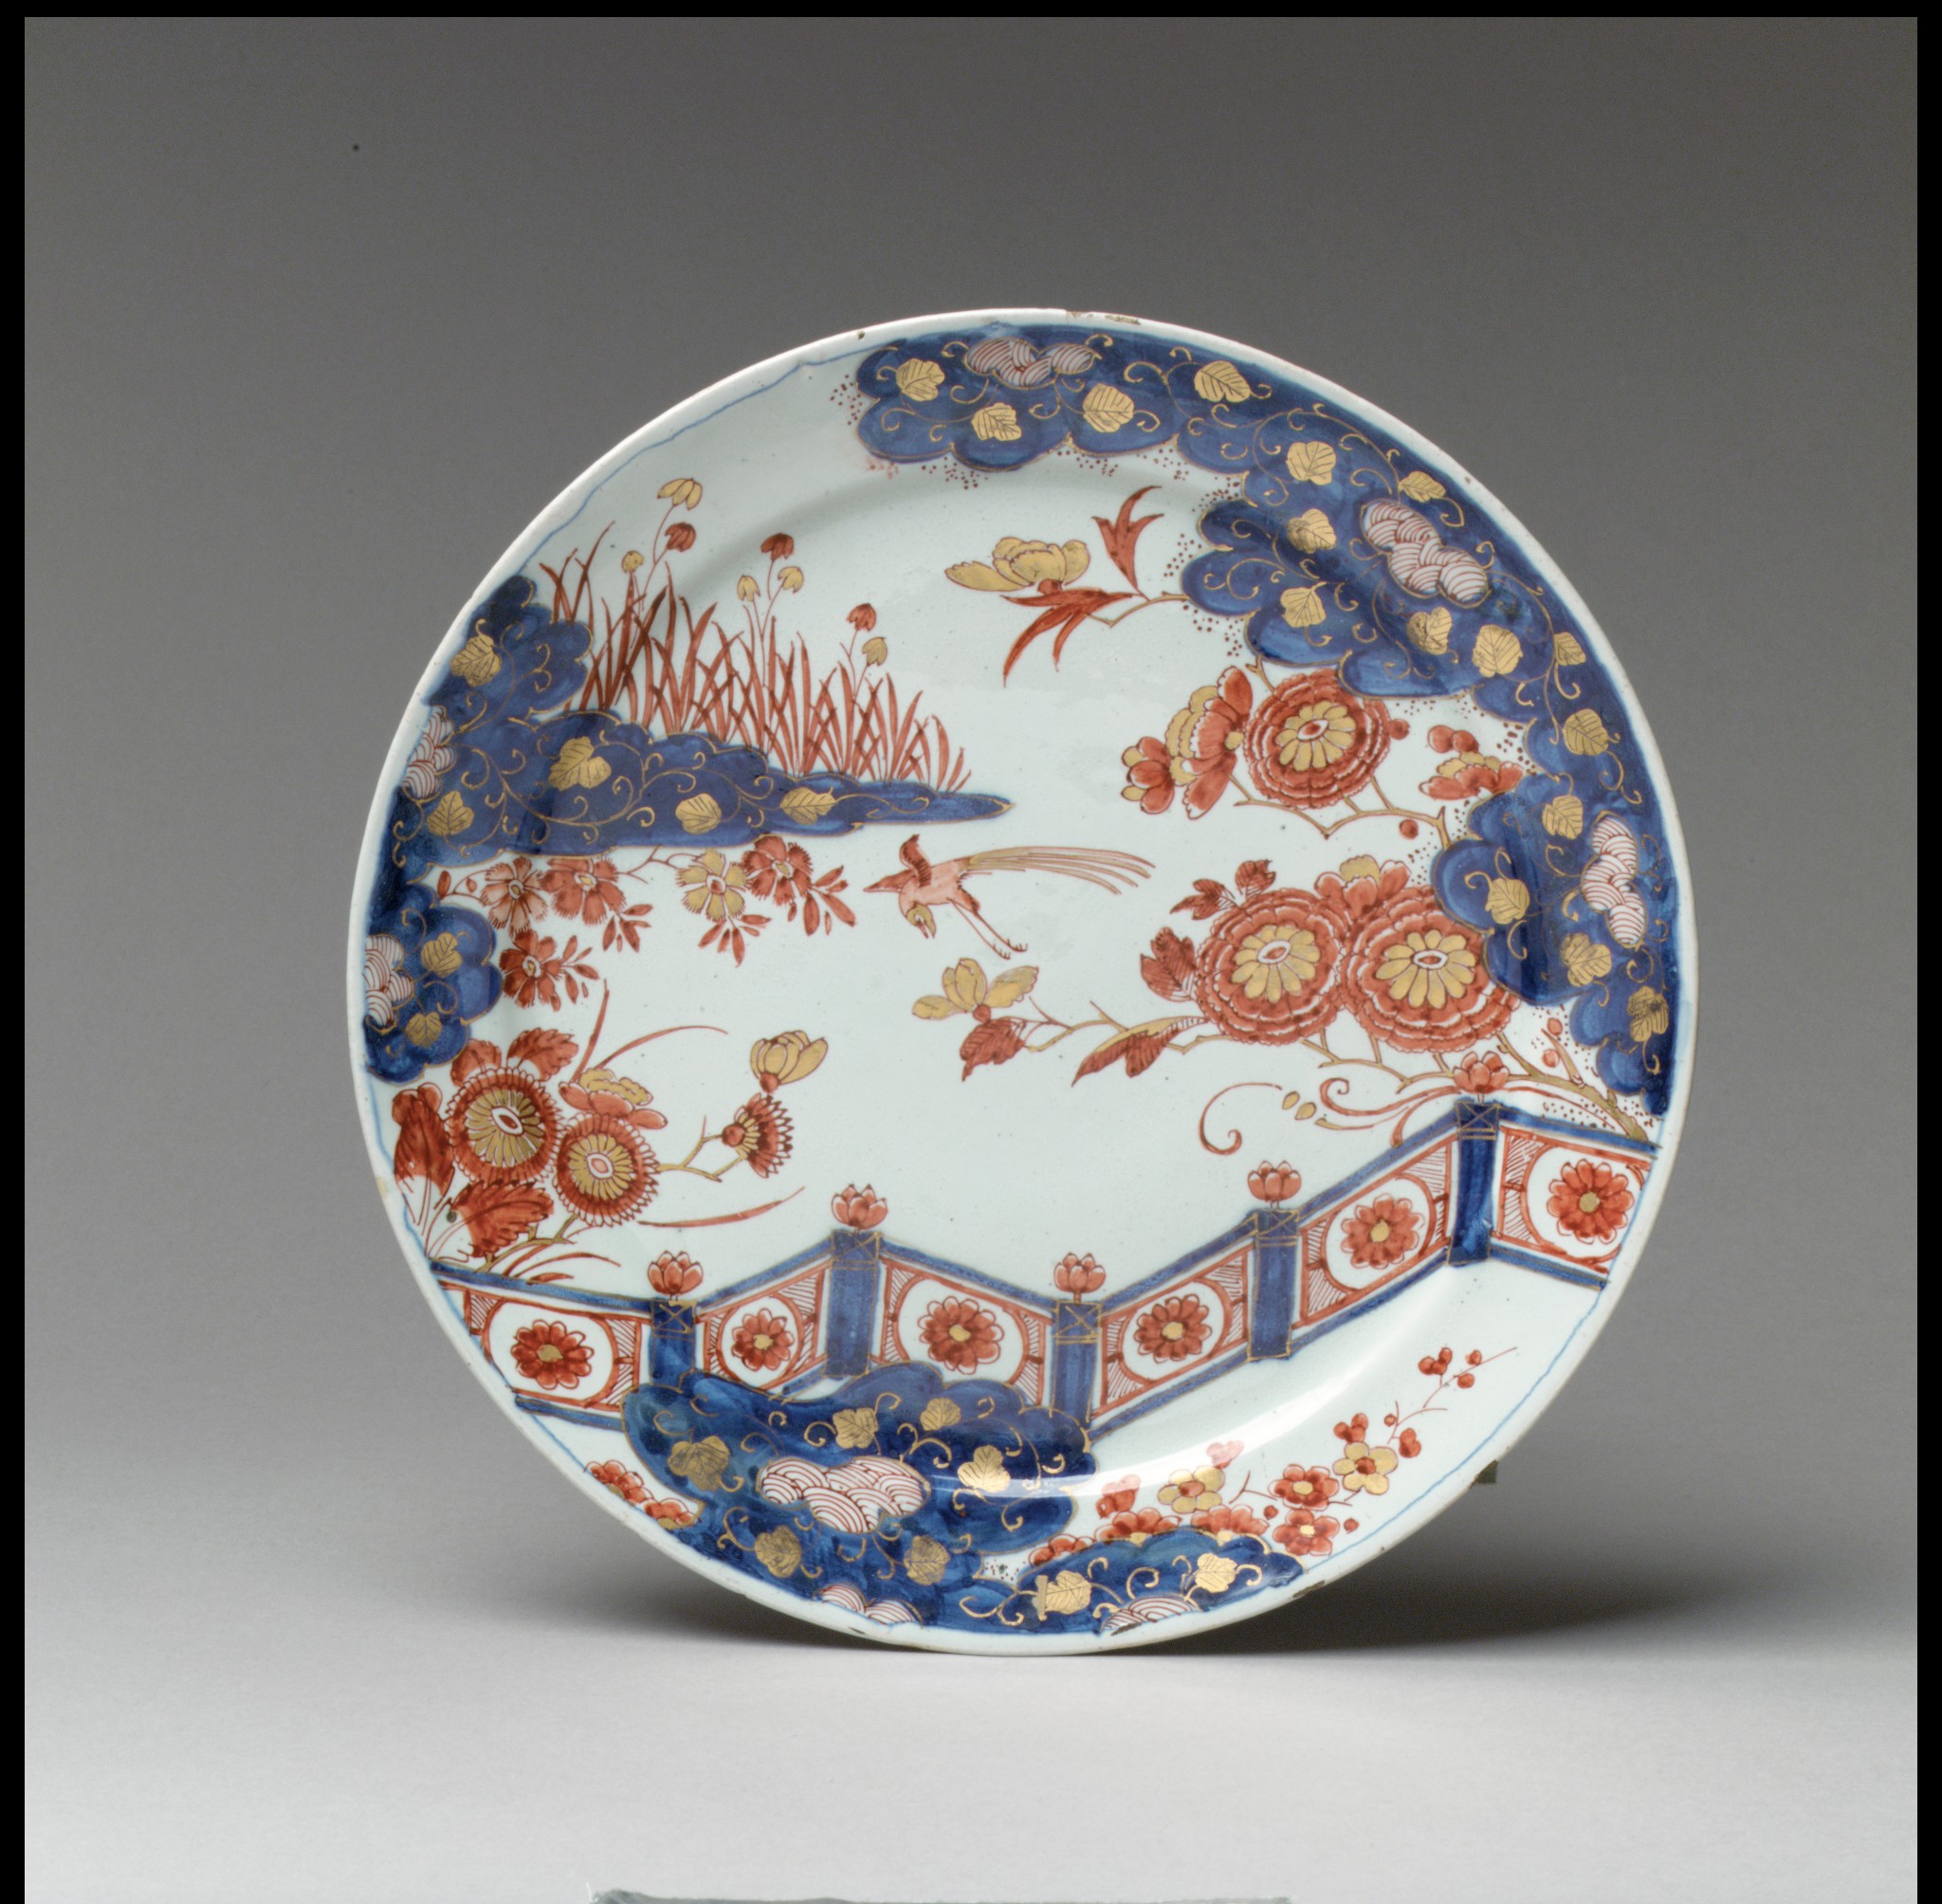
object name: plate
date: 1690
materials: earthenware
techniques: glazing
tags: birds,flowers